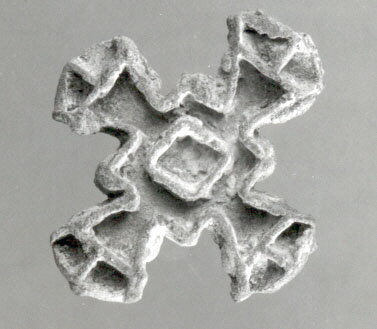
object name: stamp seal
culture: bactria-margiana archaeological complex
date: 2333-1668 BCE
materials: copper alloy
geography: bactria-margiana